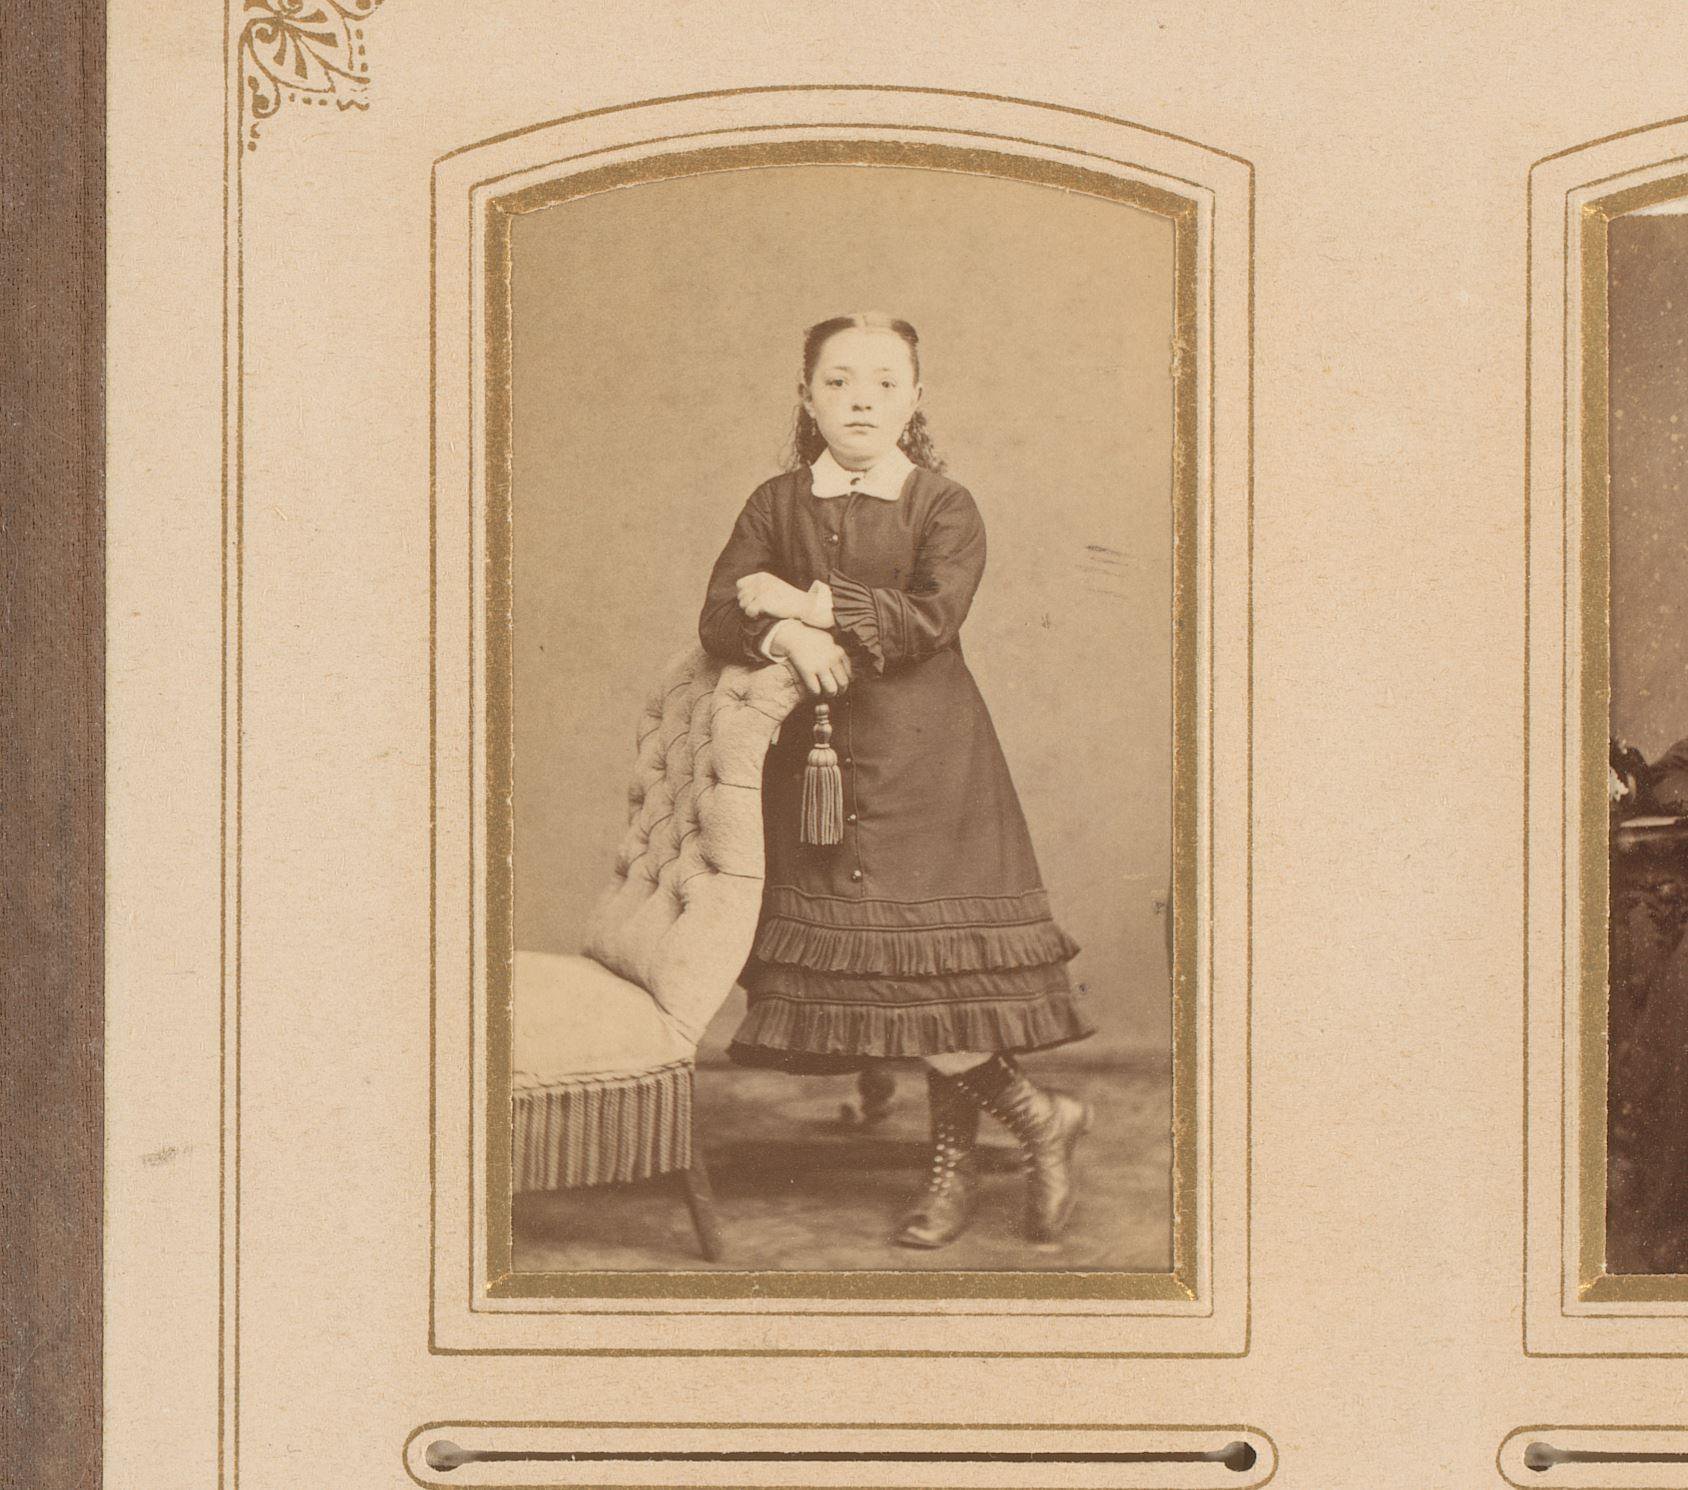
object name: photograph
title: Portret van een meisje, staand bij een stoel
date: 1873-1883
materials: cardboard, photographic support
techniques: albumen print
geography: hoorn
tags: historical persons - bb - woman, girl (child between toddler and youth), chair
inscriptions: inscription: ‘Huysen & Zoon,/ PHOTOGRAPHEN/ op het plein a/h Groote Oost/ HOORN.’